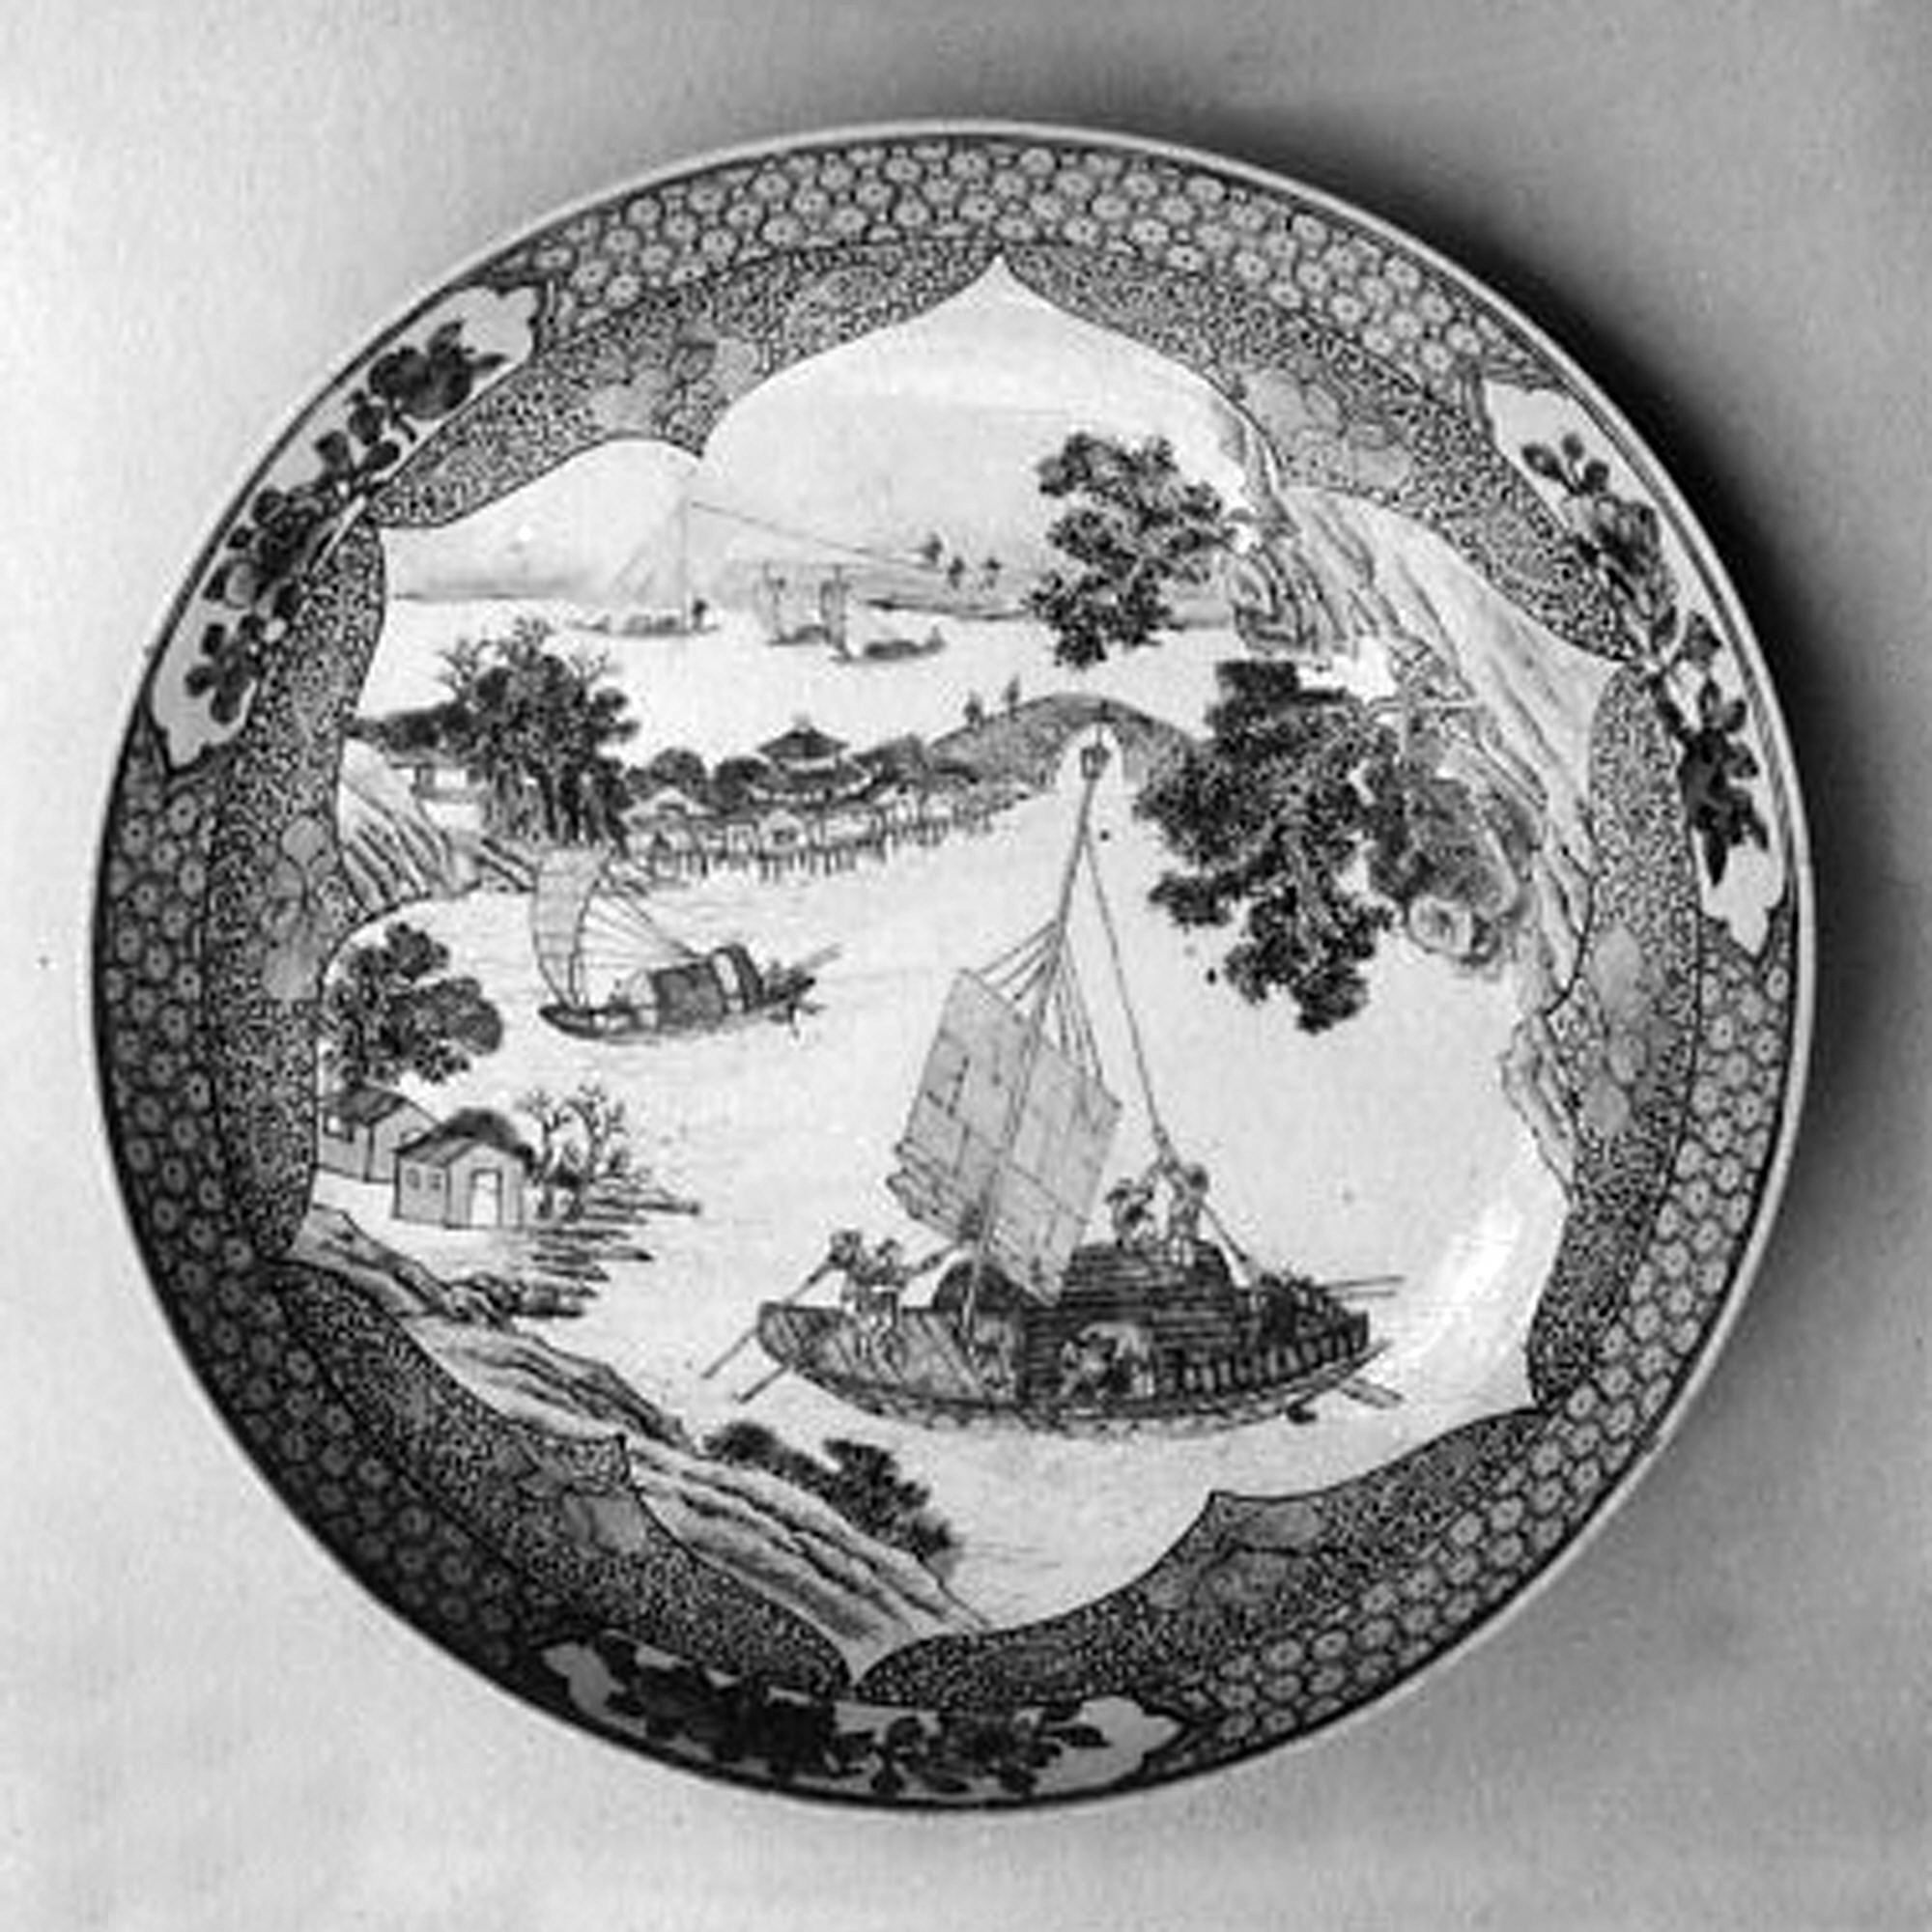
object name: plate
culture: chinese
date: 1736-1795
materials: porcelain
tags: boats